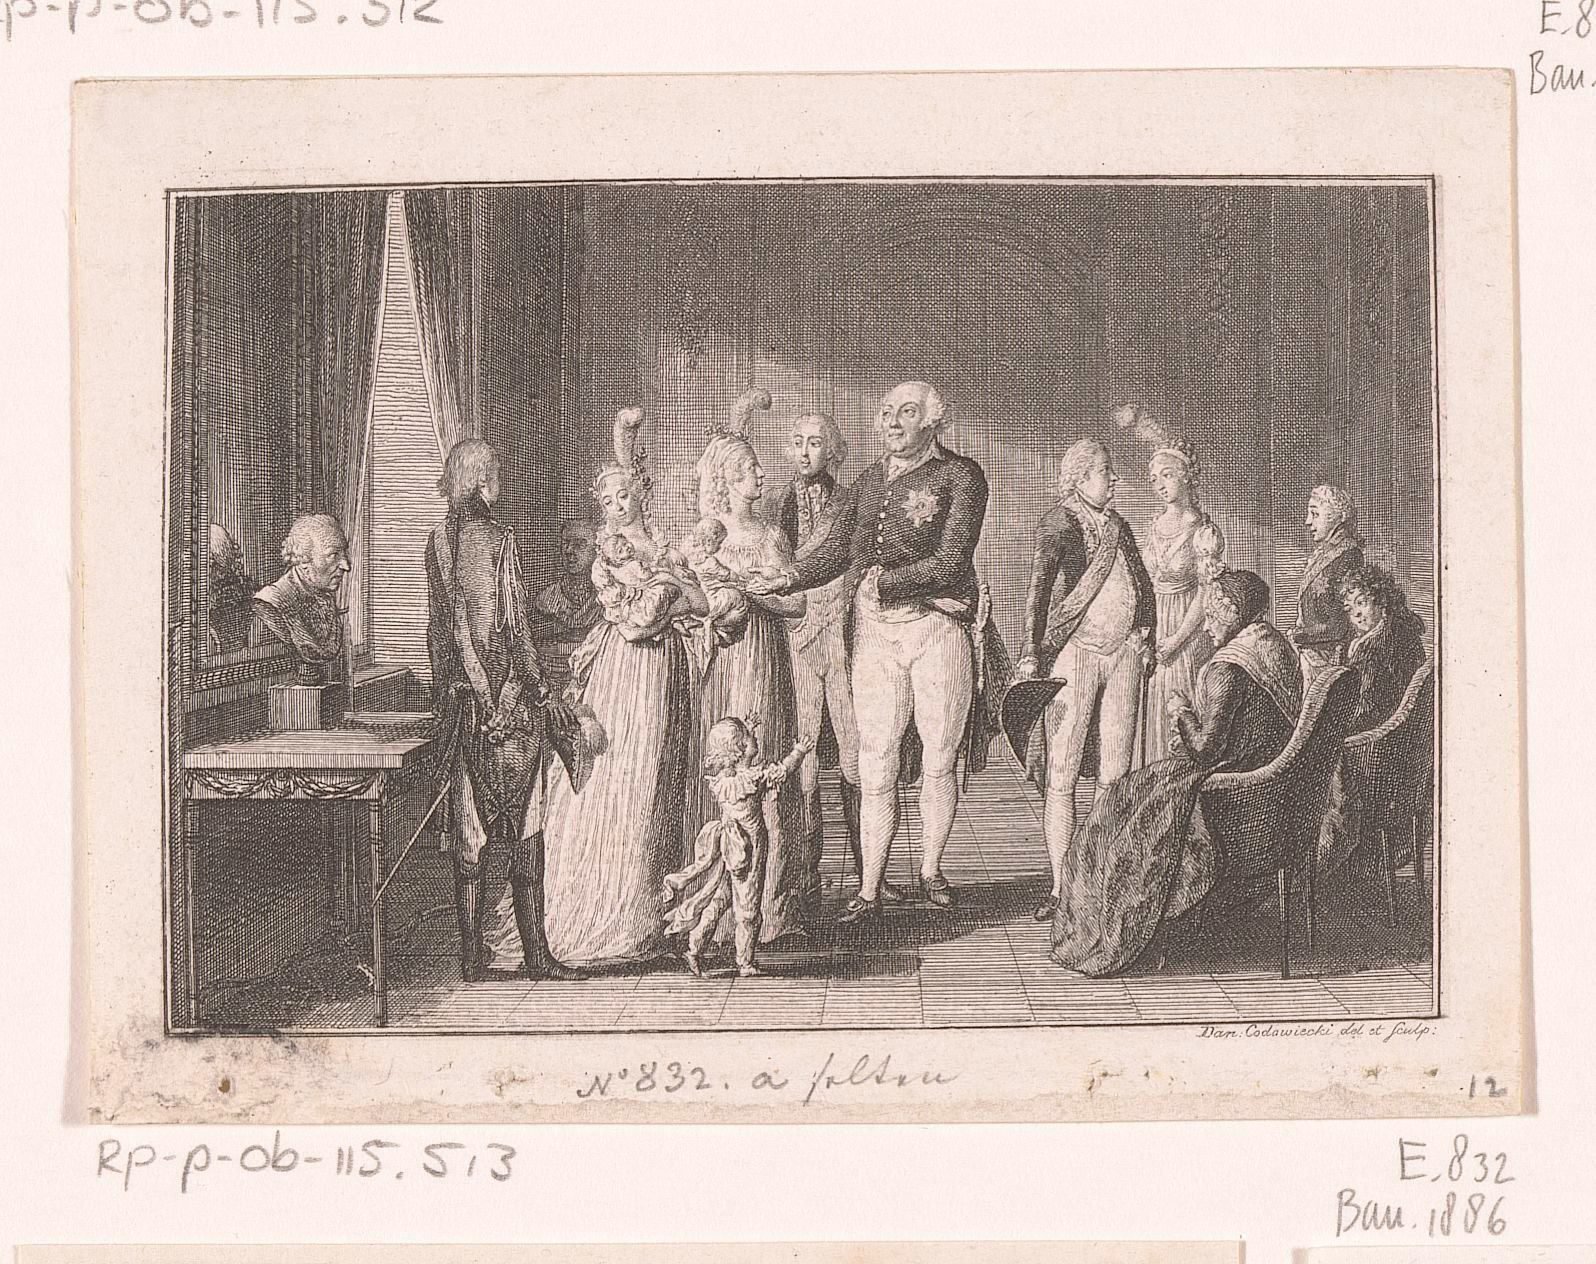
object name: print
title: Koninklijke Pruisische familie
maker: daniel nikolaus chodowiecki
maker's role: draughtsman, print maker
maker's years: 1726-1801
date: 1796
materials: paper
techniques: etching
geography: berlin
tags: berlin, frederik willem iii koning van pruisen, chest, bust, literature, family, relationship, descent, family of the sovereign